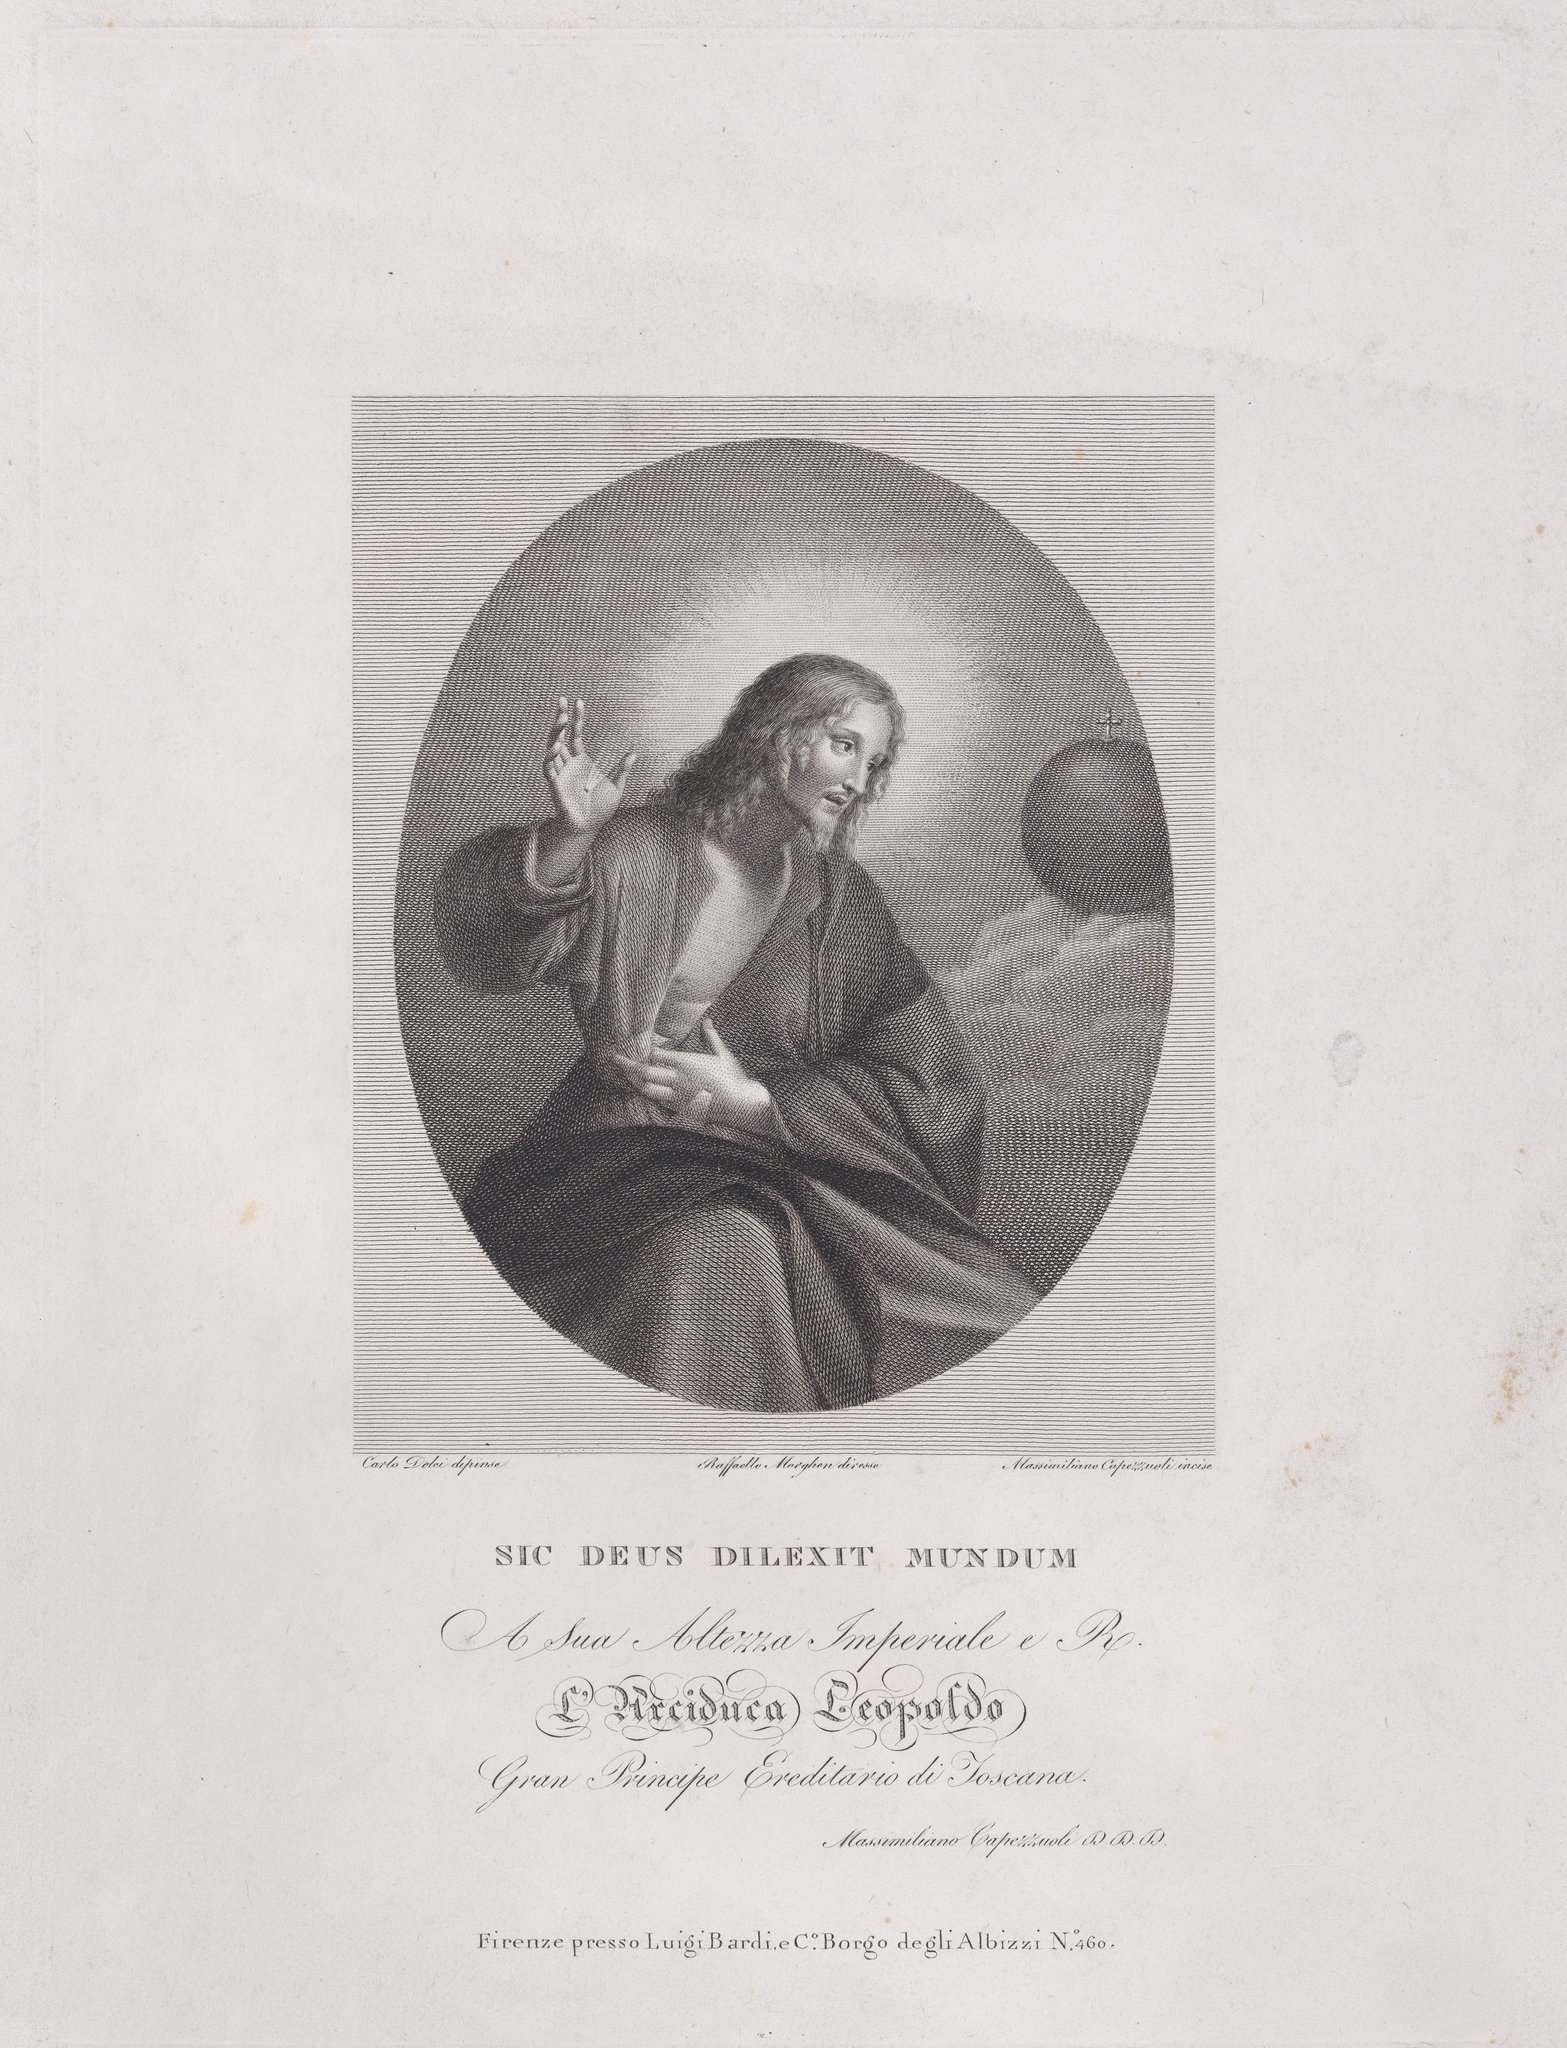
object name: print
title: Christ displaying his wounds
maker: massimiliano capezzuoli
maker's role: artist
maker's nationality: italian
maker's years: 1800-1900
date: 1814-1843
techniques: engraving